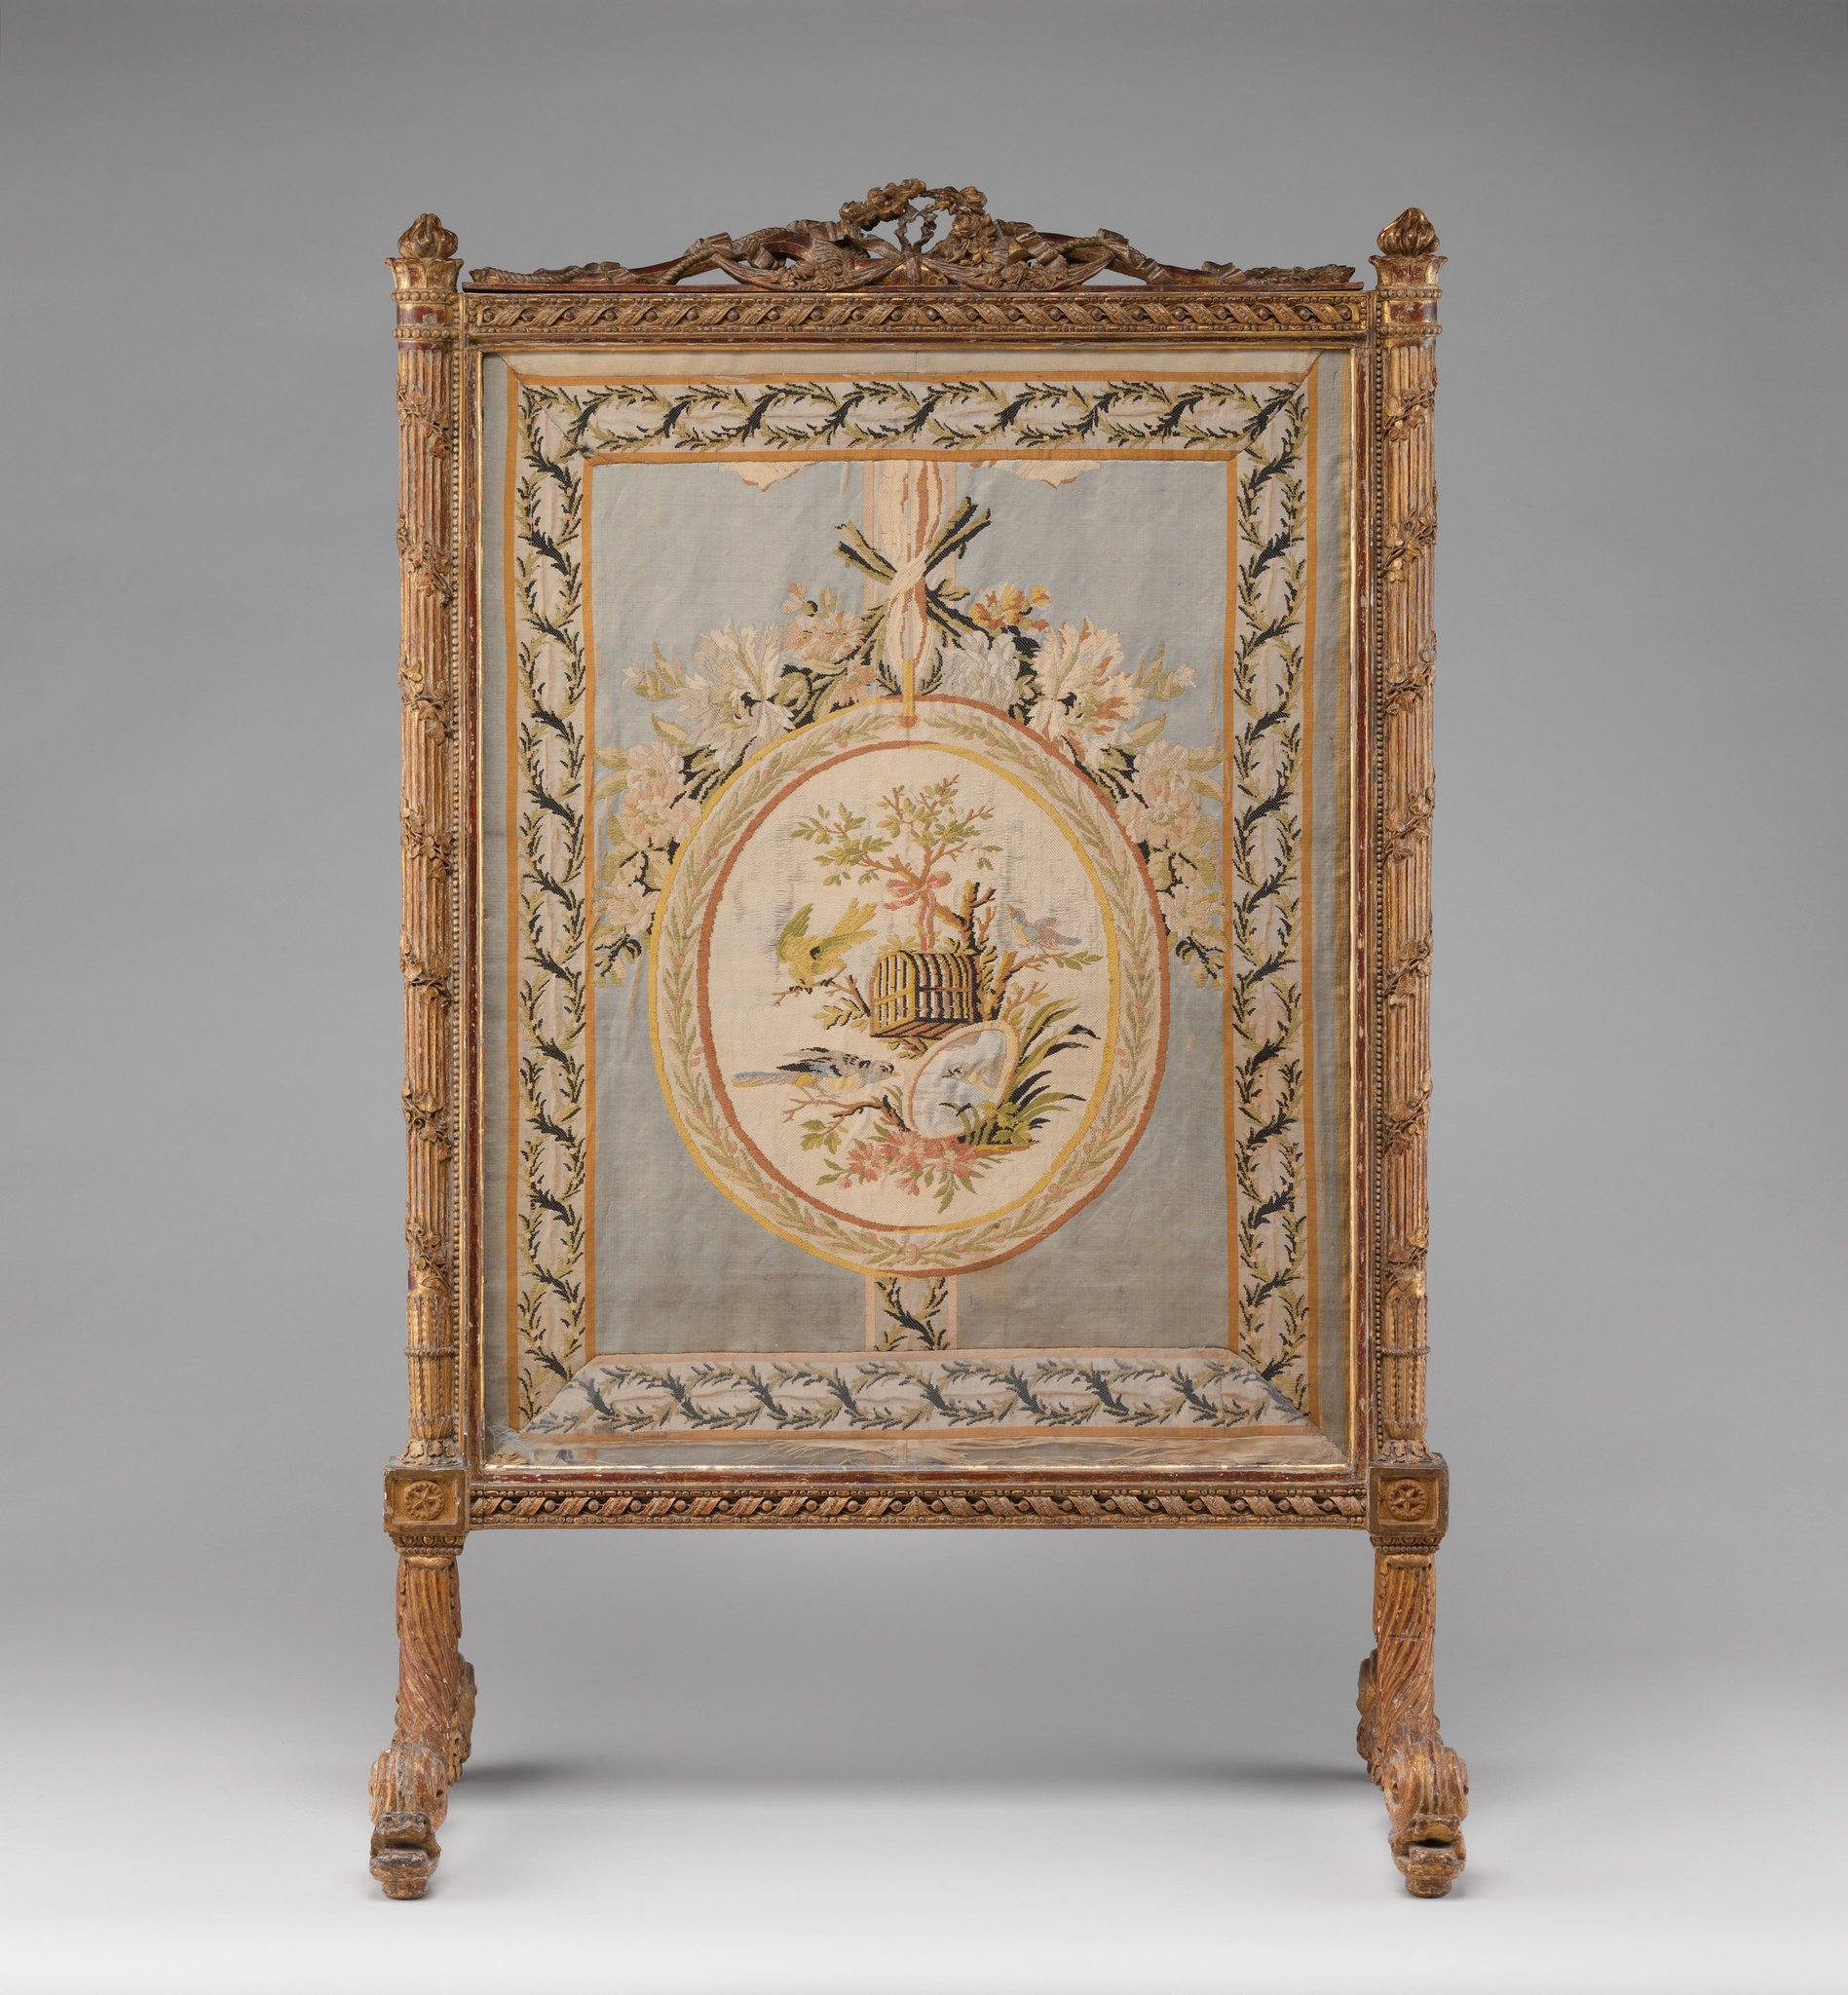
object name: fire screen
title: Fire screen (écran)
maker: georges jacob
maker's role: maker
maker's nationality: french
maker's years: 1739-1814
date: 1786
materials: wood, silk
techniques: brocade, carving, gilding, silvered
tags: birds